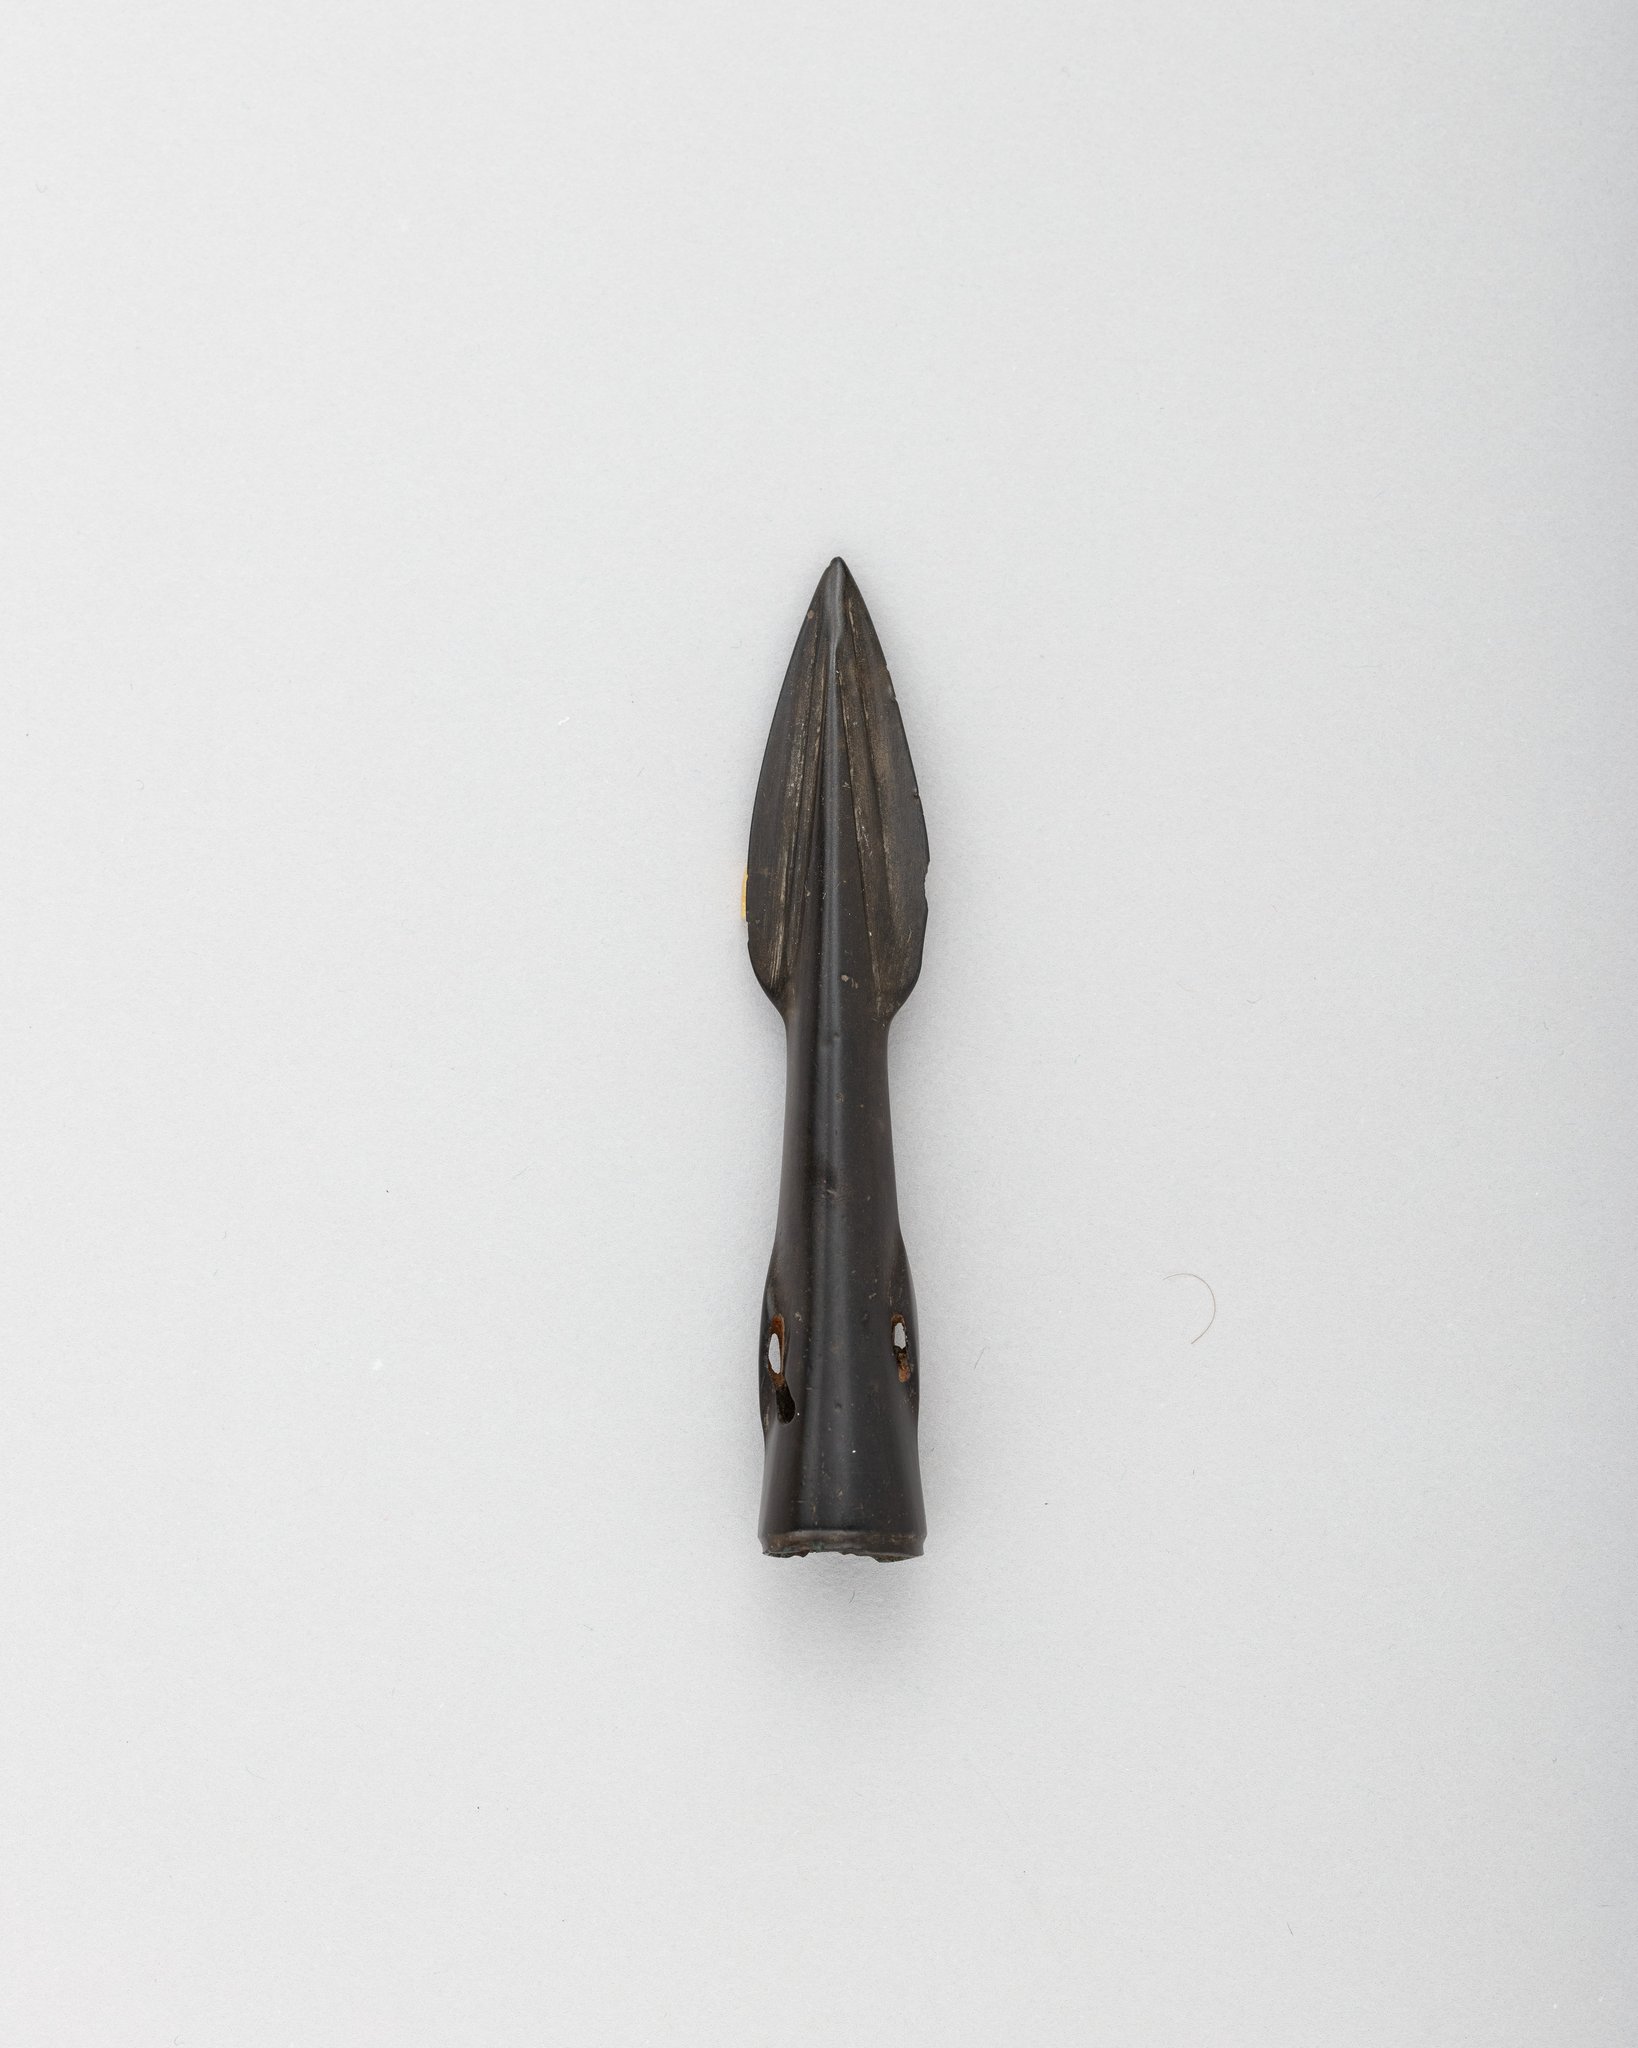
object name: spearhead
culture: british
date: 1400-1300 BCE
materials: bronze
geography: england